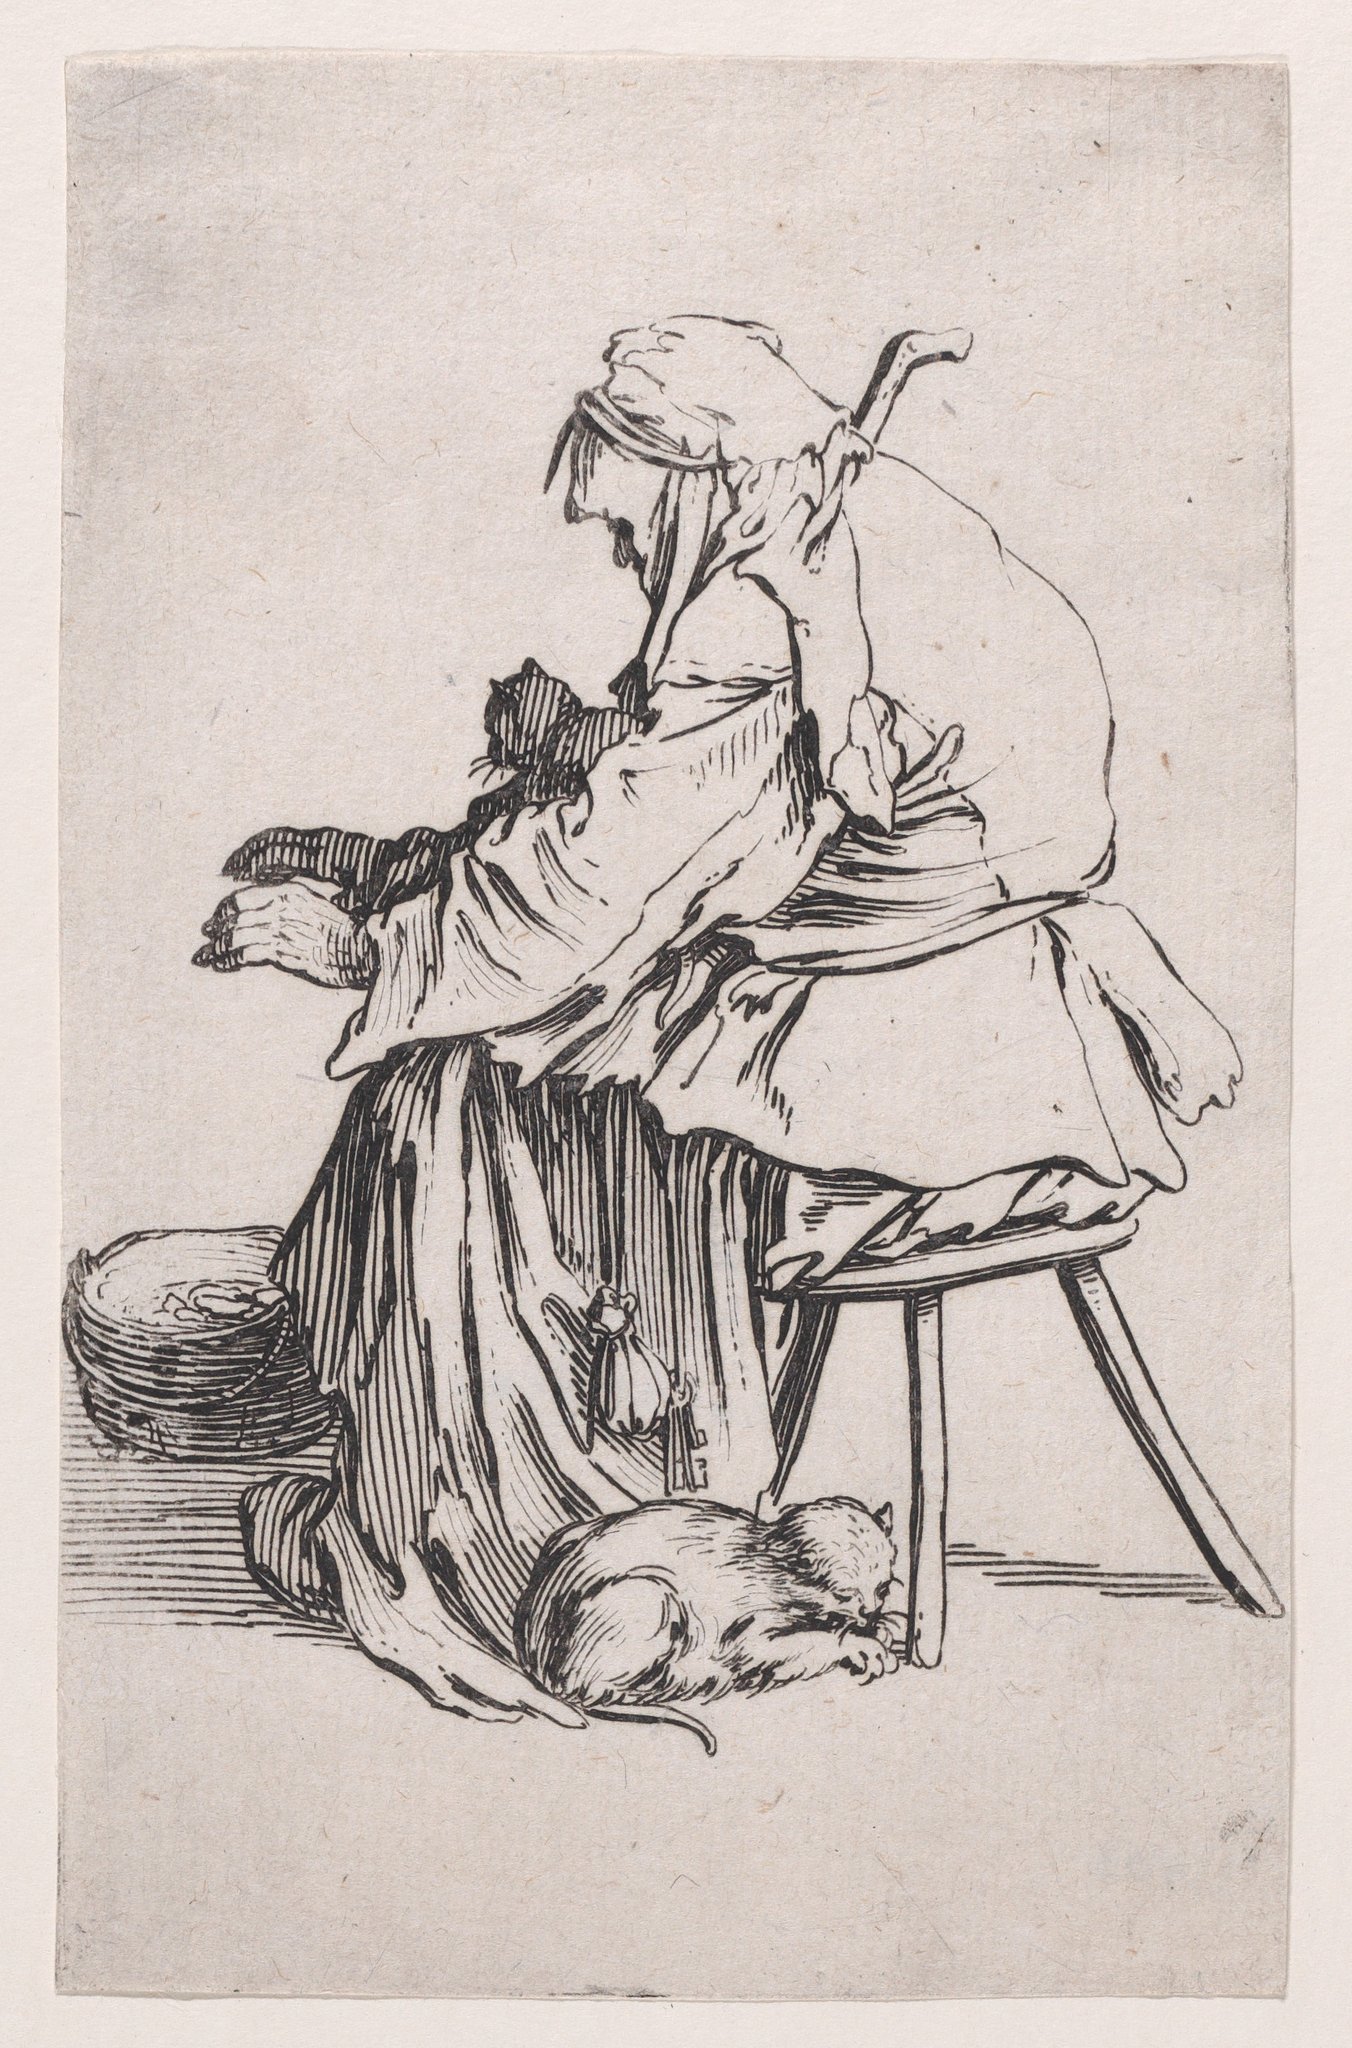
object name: print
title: La Vieille aux Chats (The Old Woman with Cats), from "Les Gueux suite appelée aussi Les Mendiants, Les Baroni, ou Les Barons" (The Beggars, also called the Barons)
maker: jacques callot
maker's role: artist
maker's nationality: french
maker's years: 1592-1635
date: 1623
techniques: etching